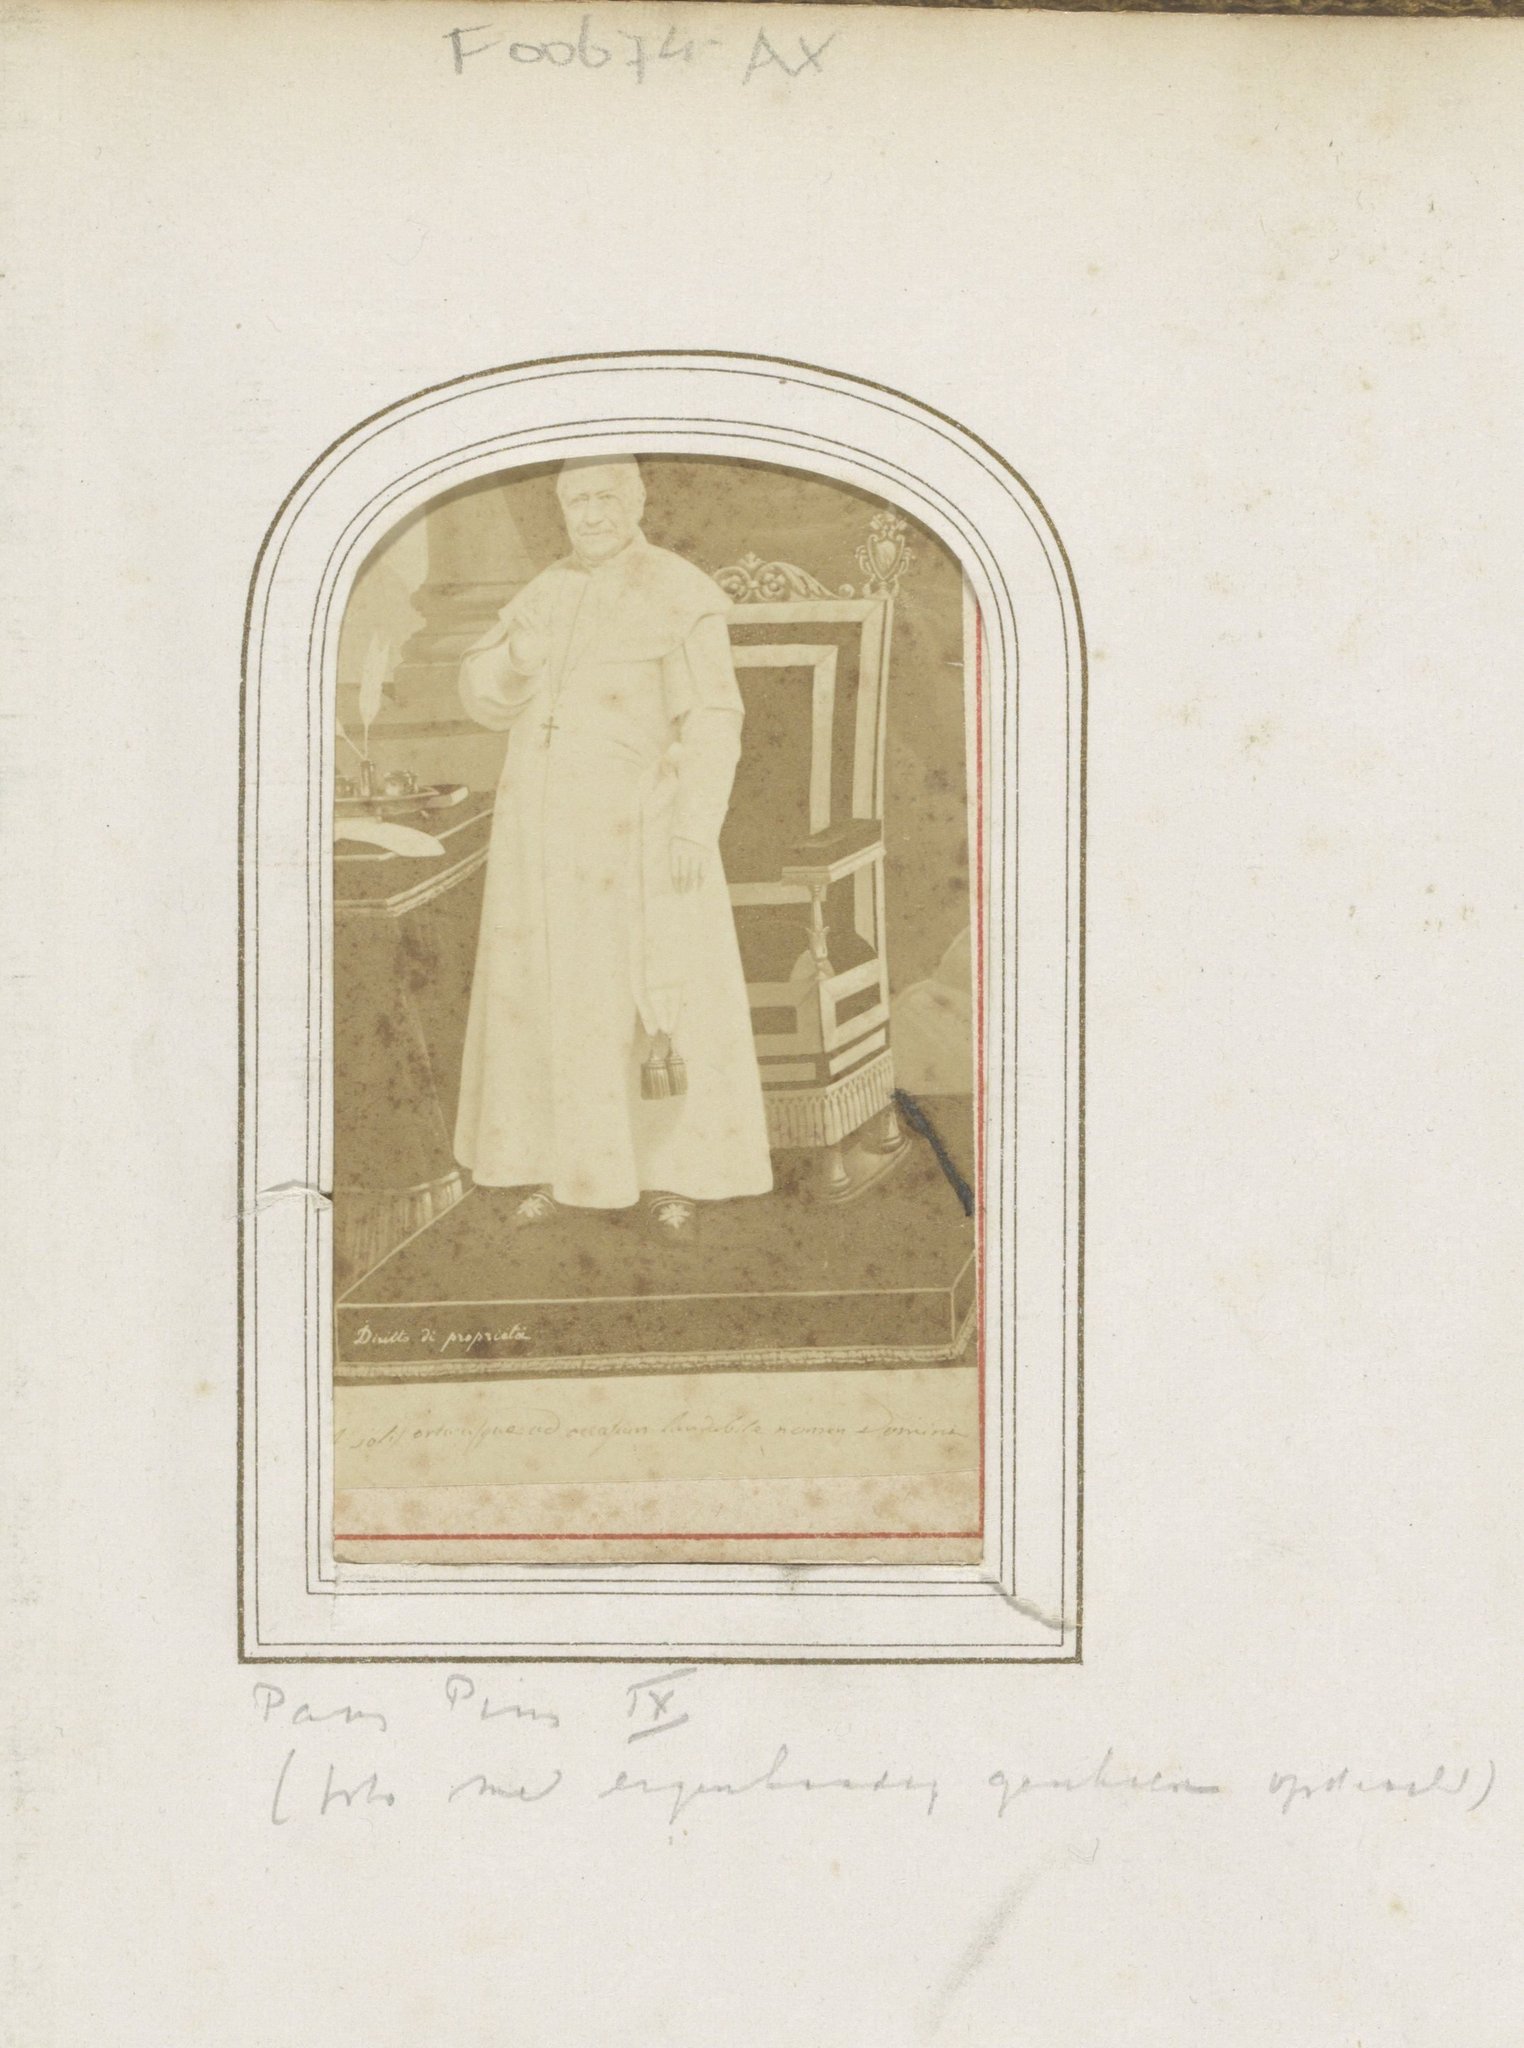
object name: reproduction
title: Fotoreproductie van (vermoedelijk) een prent van paus Pius IX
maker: Anonymous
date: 1865-1878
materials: cardboard, paper, photographic support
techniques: albumen print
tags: rome, writing-table, writing-desk, liturgical vestments, canonicals, altarcross, crucifix, historical persons, throne, pope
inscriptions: inscription: ‘a ' la famille manda[...], avec la benediction de Pio IX.’, inscription: ‘A soli orta[..] ad [...] landile nomine Domine’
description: Onderdeel van Fotoalbum met 123 cartes-de-visite van leden van Europese vorstenhuizen, politici en bekende personen.